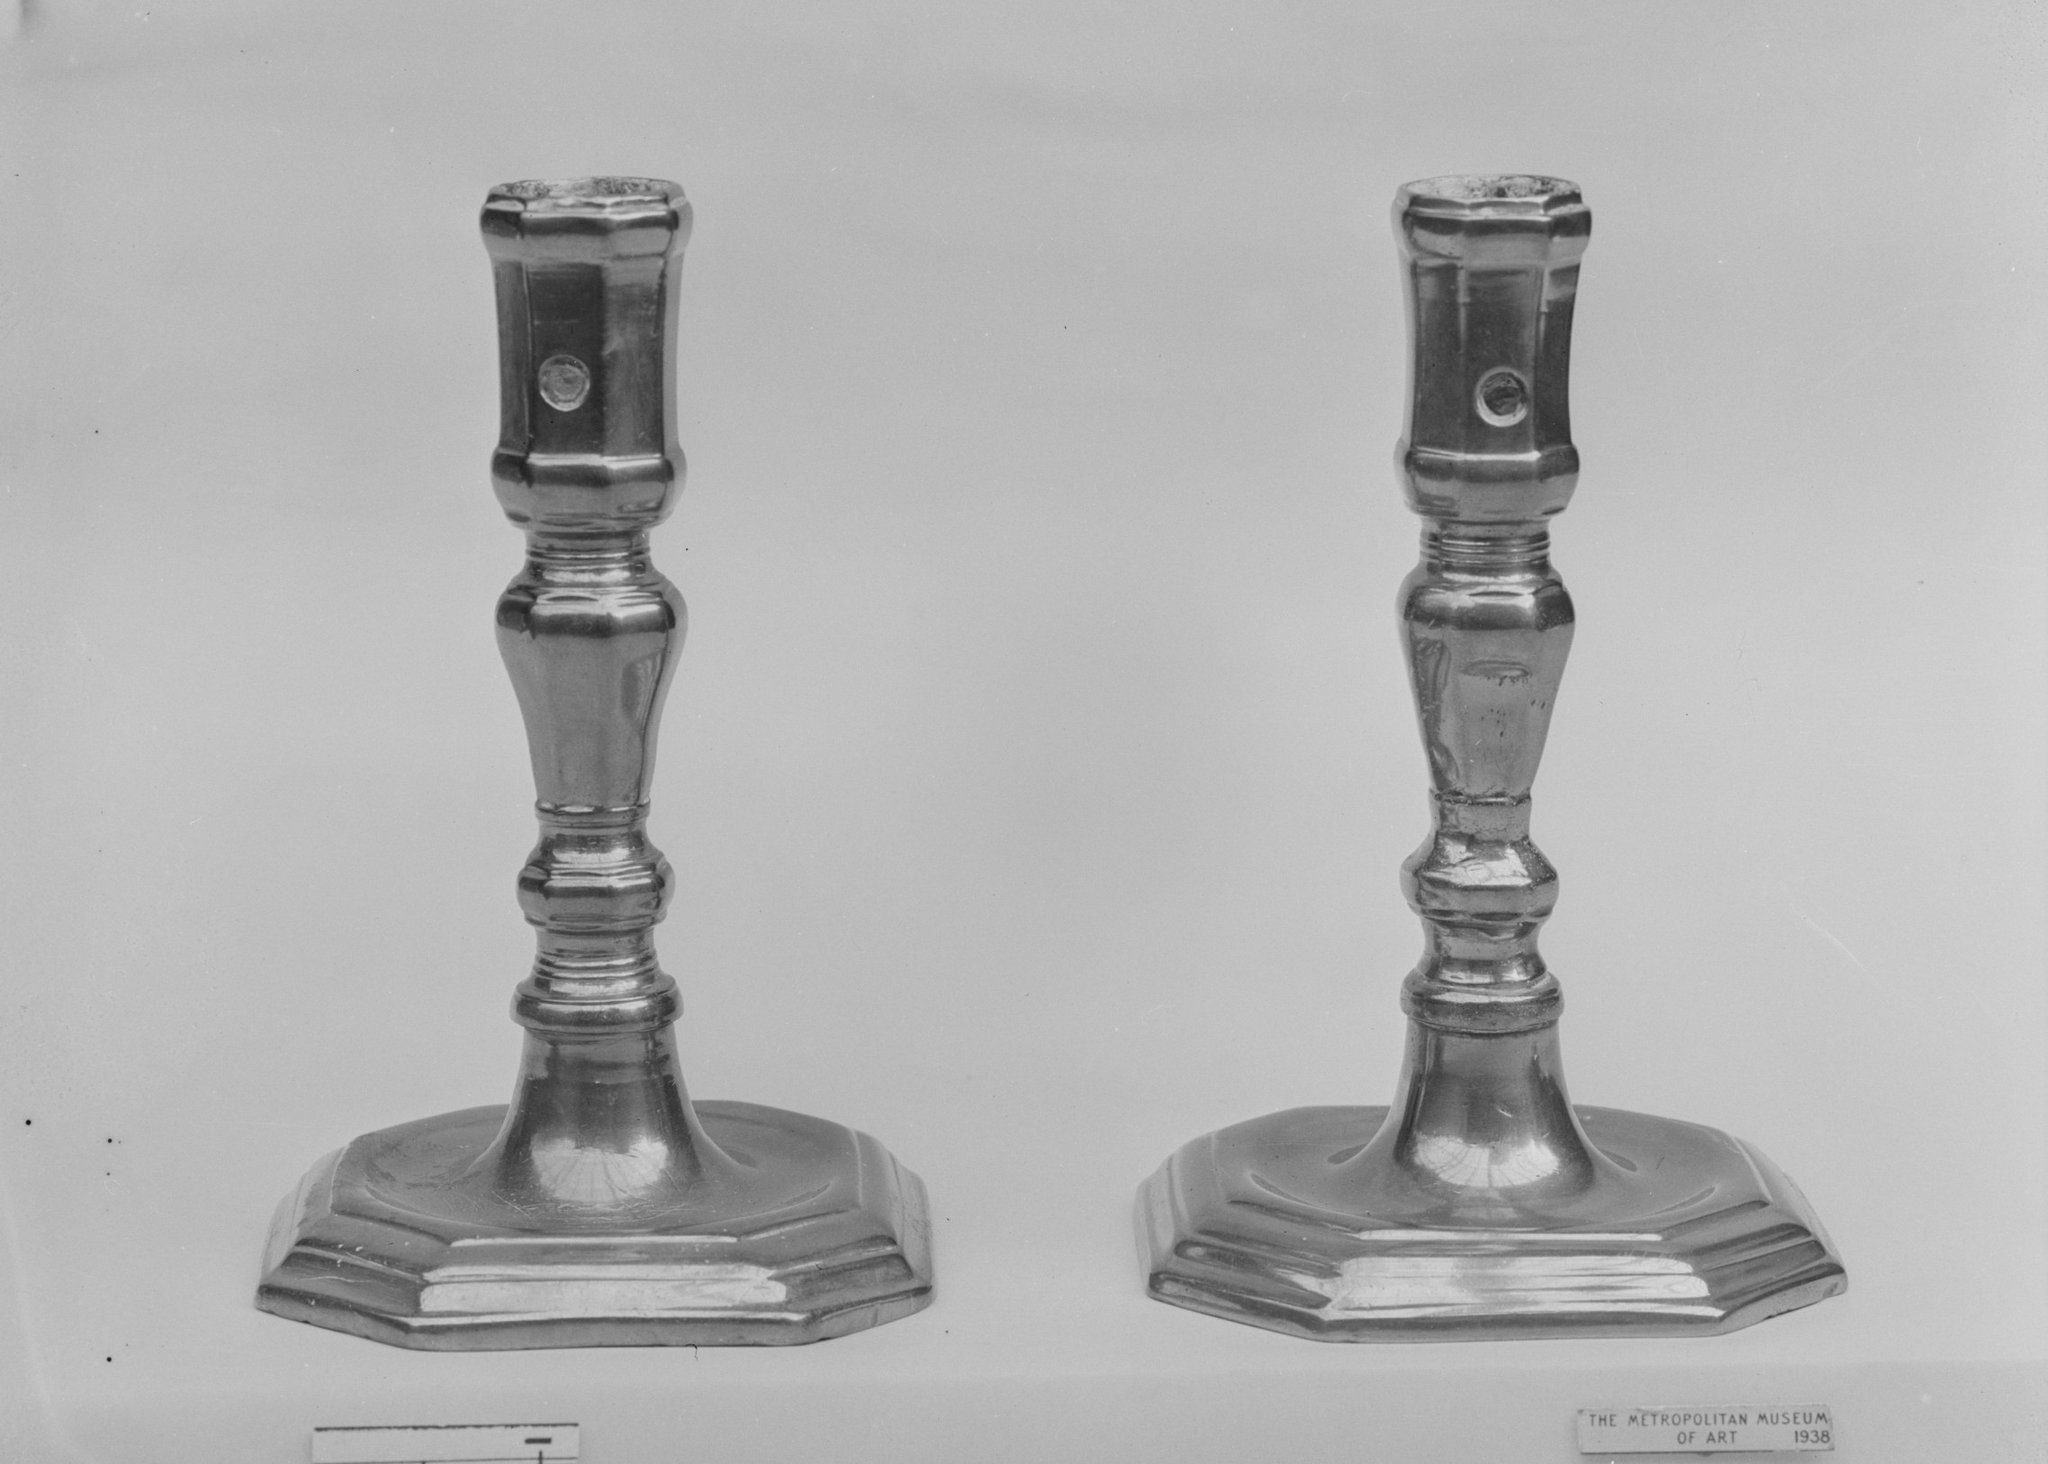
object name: candlestick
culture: american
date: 1720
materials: brass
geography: united states